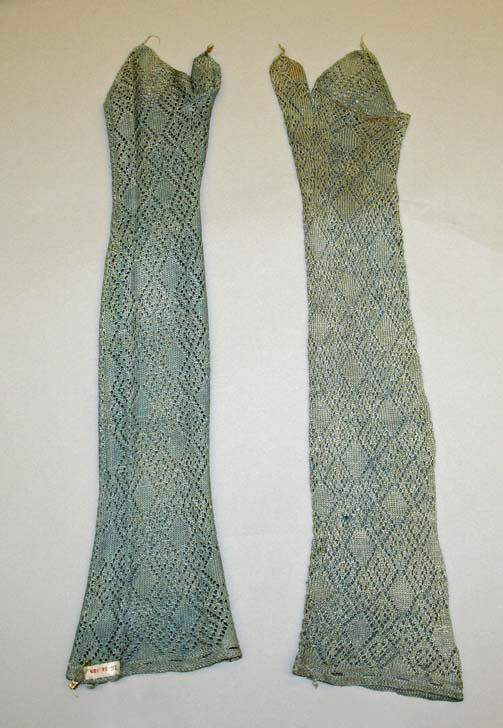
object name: mitt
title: Mitts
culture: italian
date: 1850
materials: silk